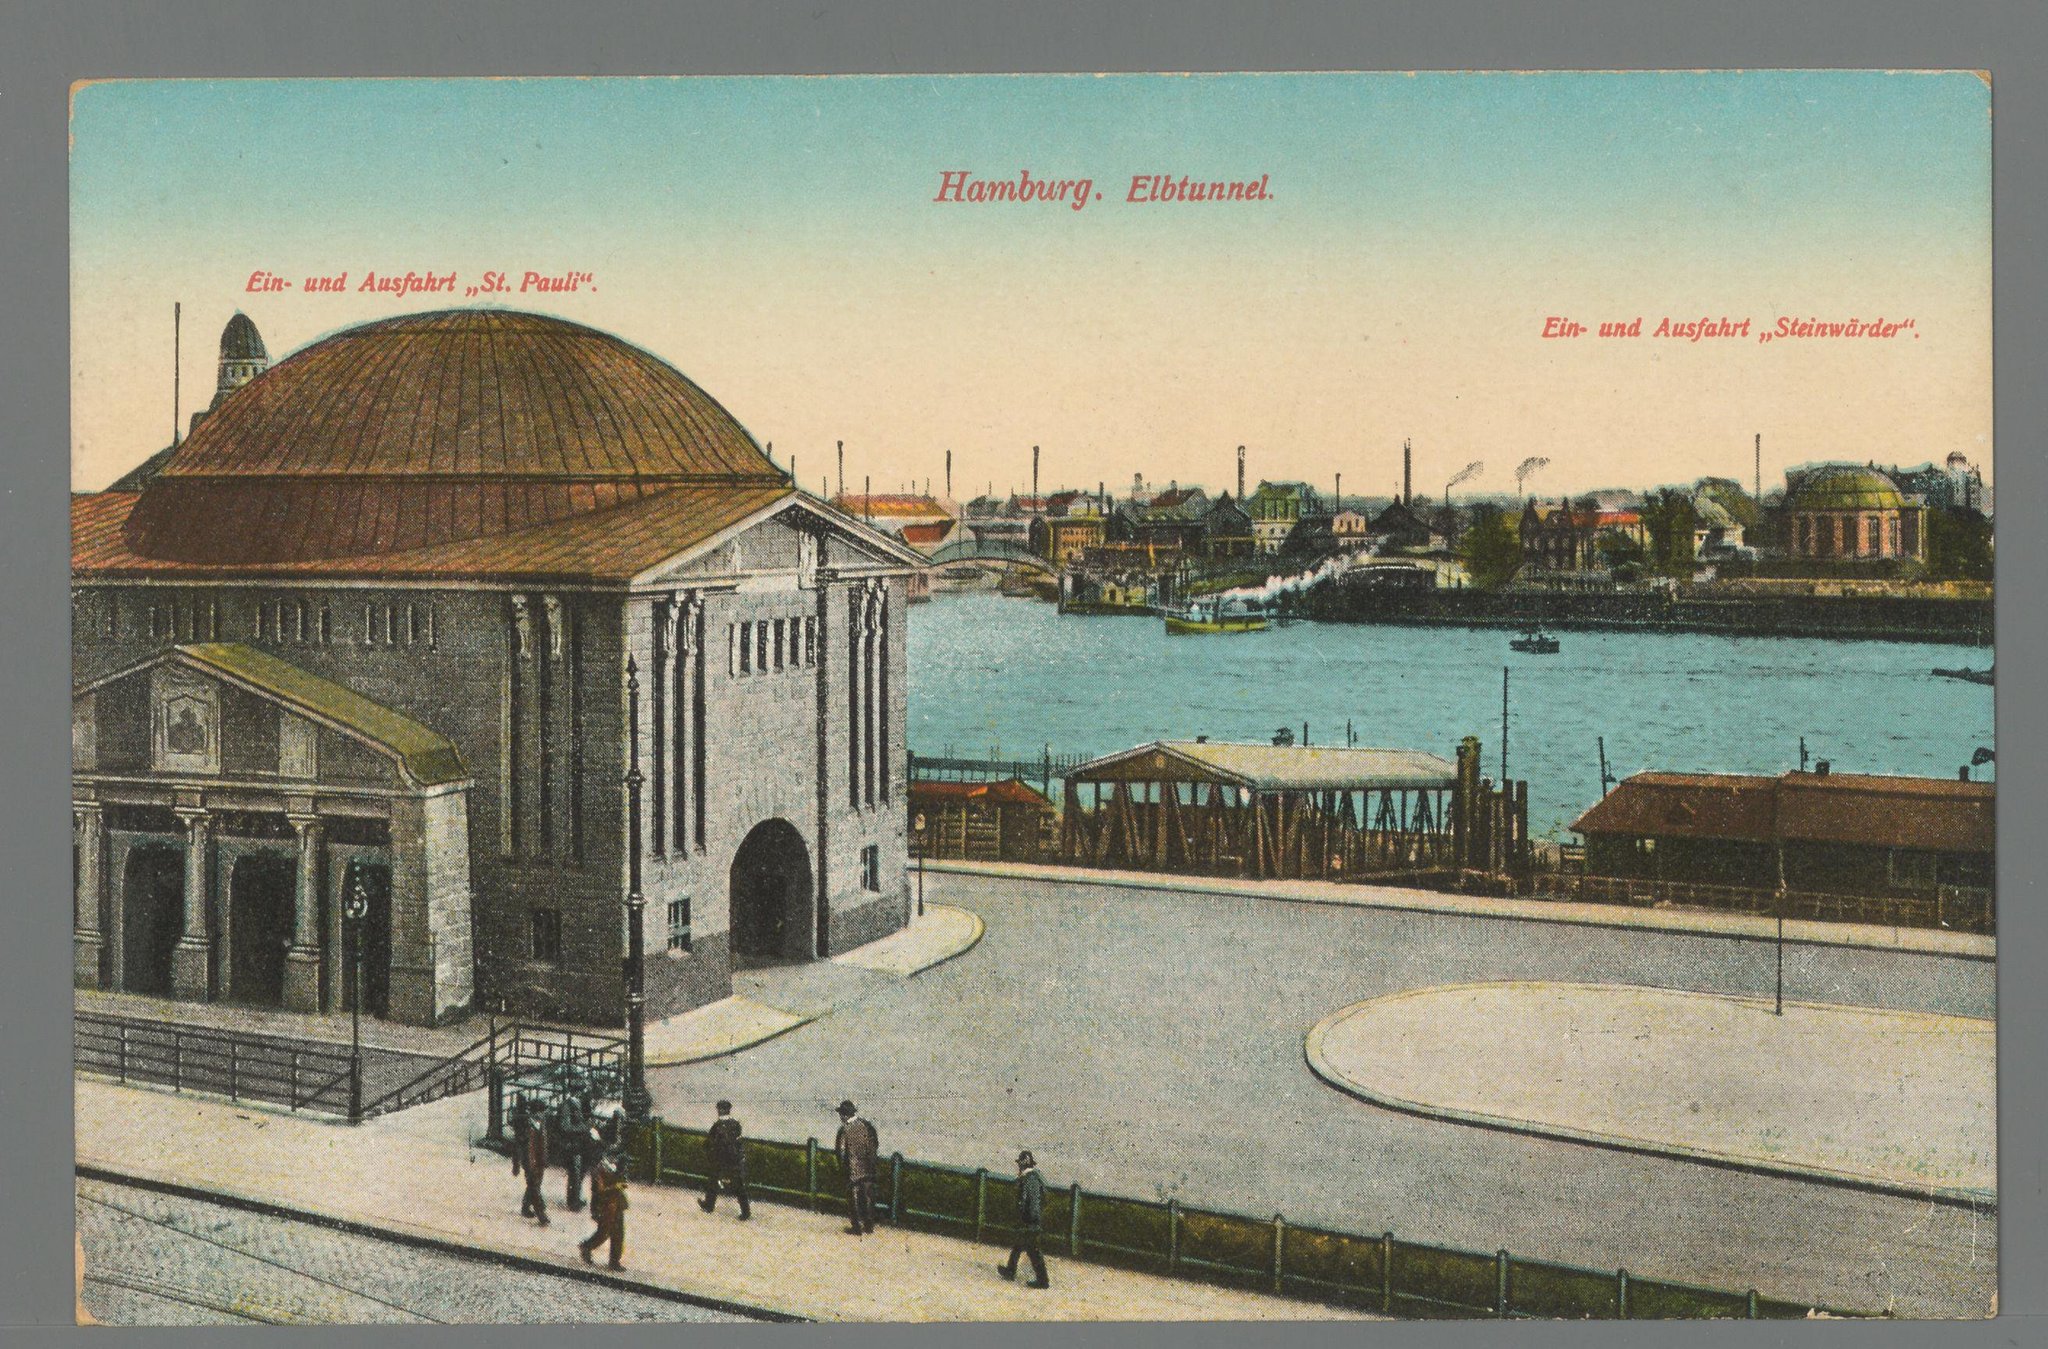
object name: photomechanical print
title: Hamburg. Elbtunnel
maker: Anonymous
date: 1911-1930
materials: cardboard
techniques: lithograph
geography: hamburg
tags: canals, waters (in city), underground road, tunnel